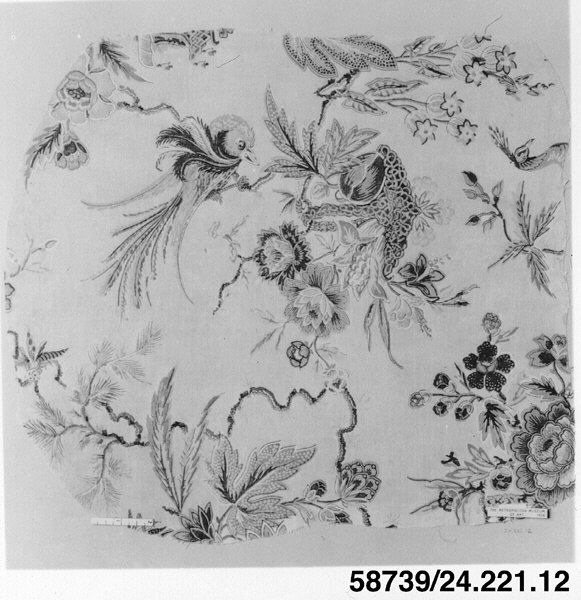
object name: piece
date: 1840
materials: linen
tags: birds,flowers